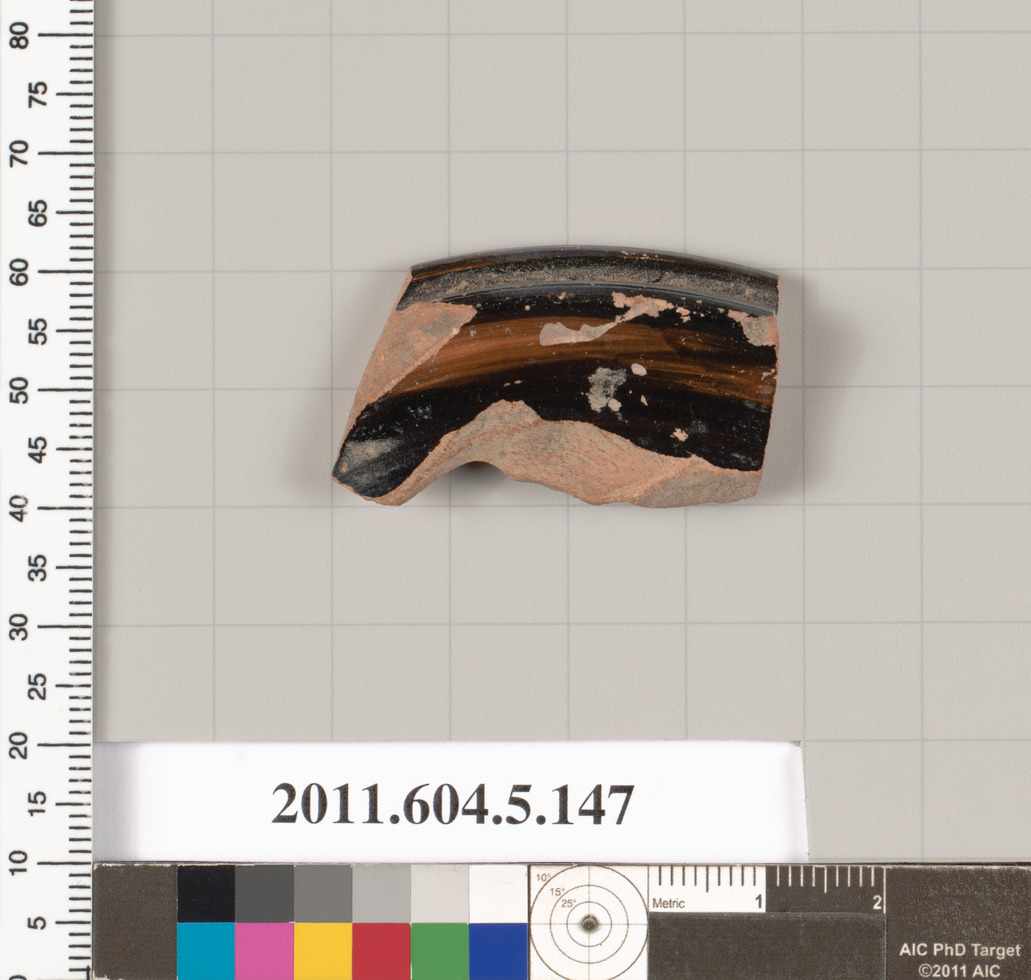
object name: kylix fragment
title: Terracotta fragment of a kylix (drinking cup)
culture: greek, attic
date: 600-401 BCE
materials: terracotta